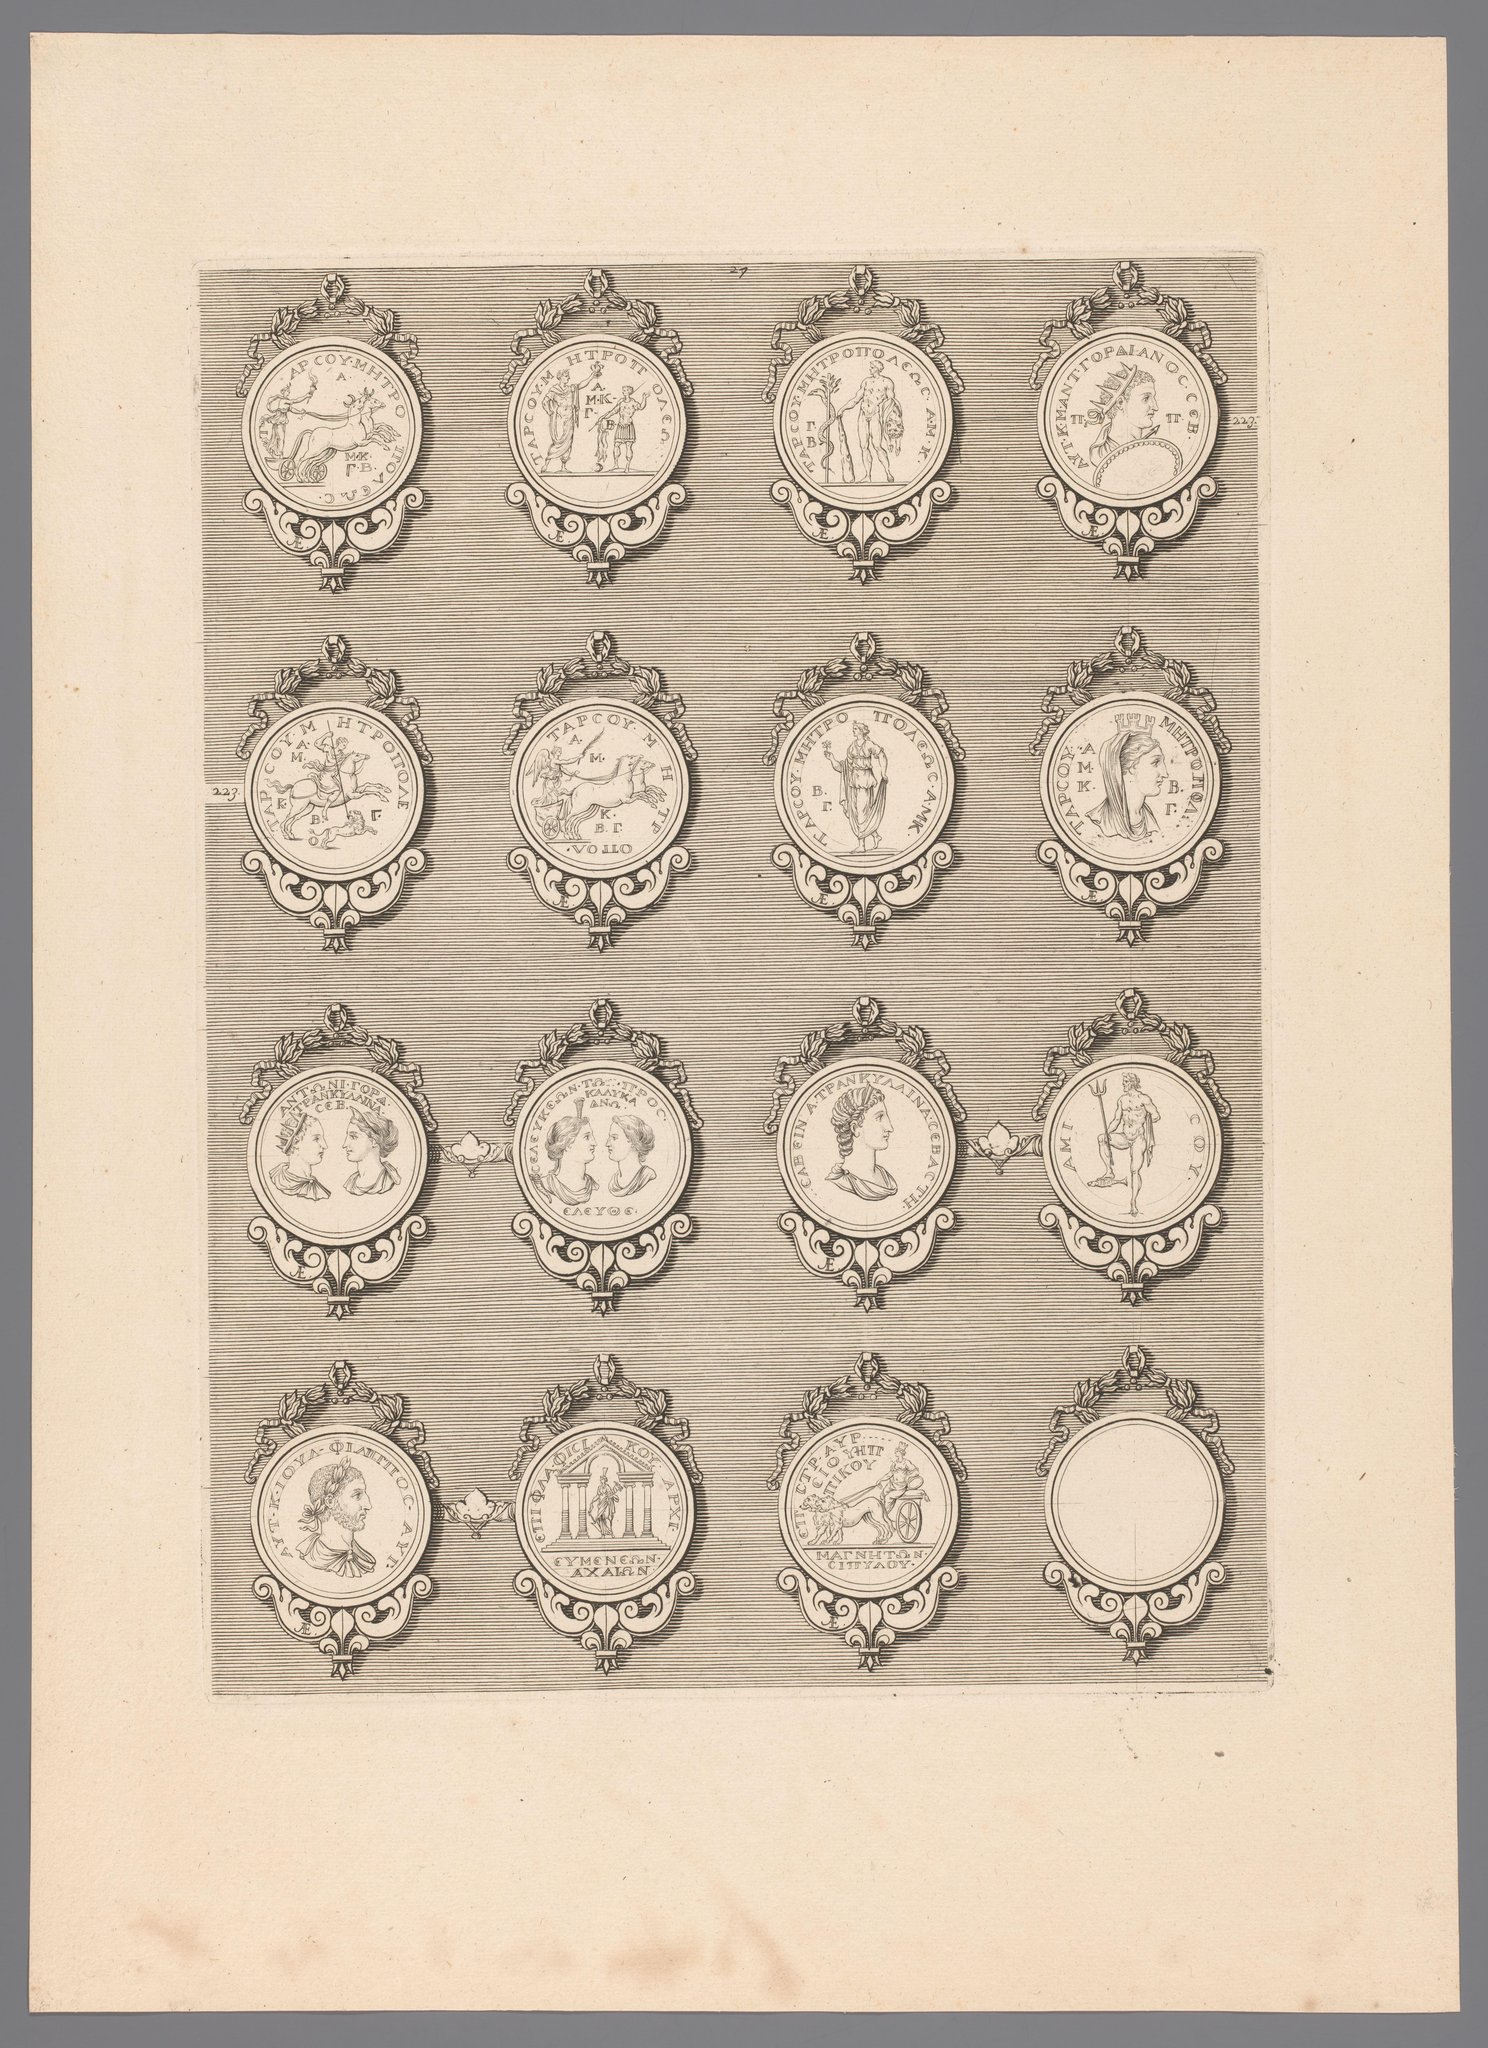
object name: print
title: Zestien penningen met versierde lijsten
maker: simon de la boissière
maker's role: print maker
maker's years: 1637-1682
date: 1647-1682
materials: paper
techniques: etching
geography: france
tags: medal (considered as a piece of sculpture, regardless of its specific function)